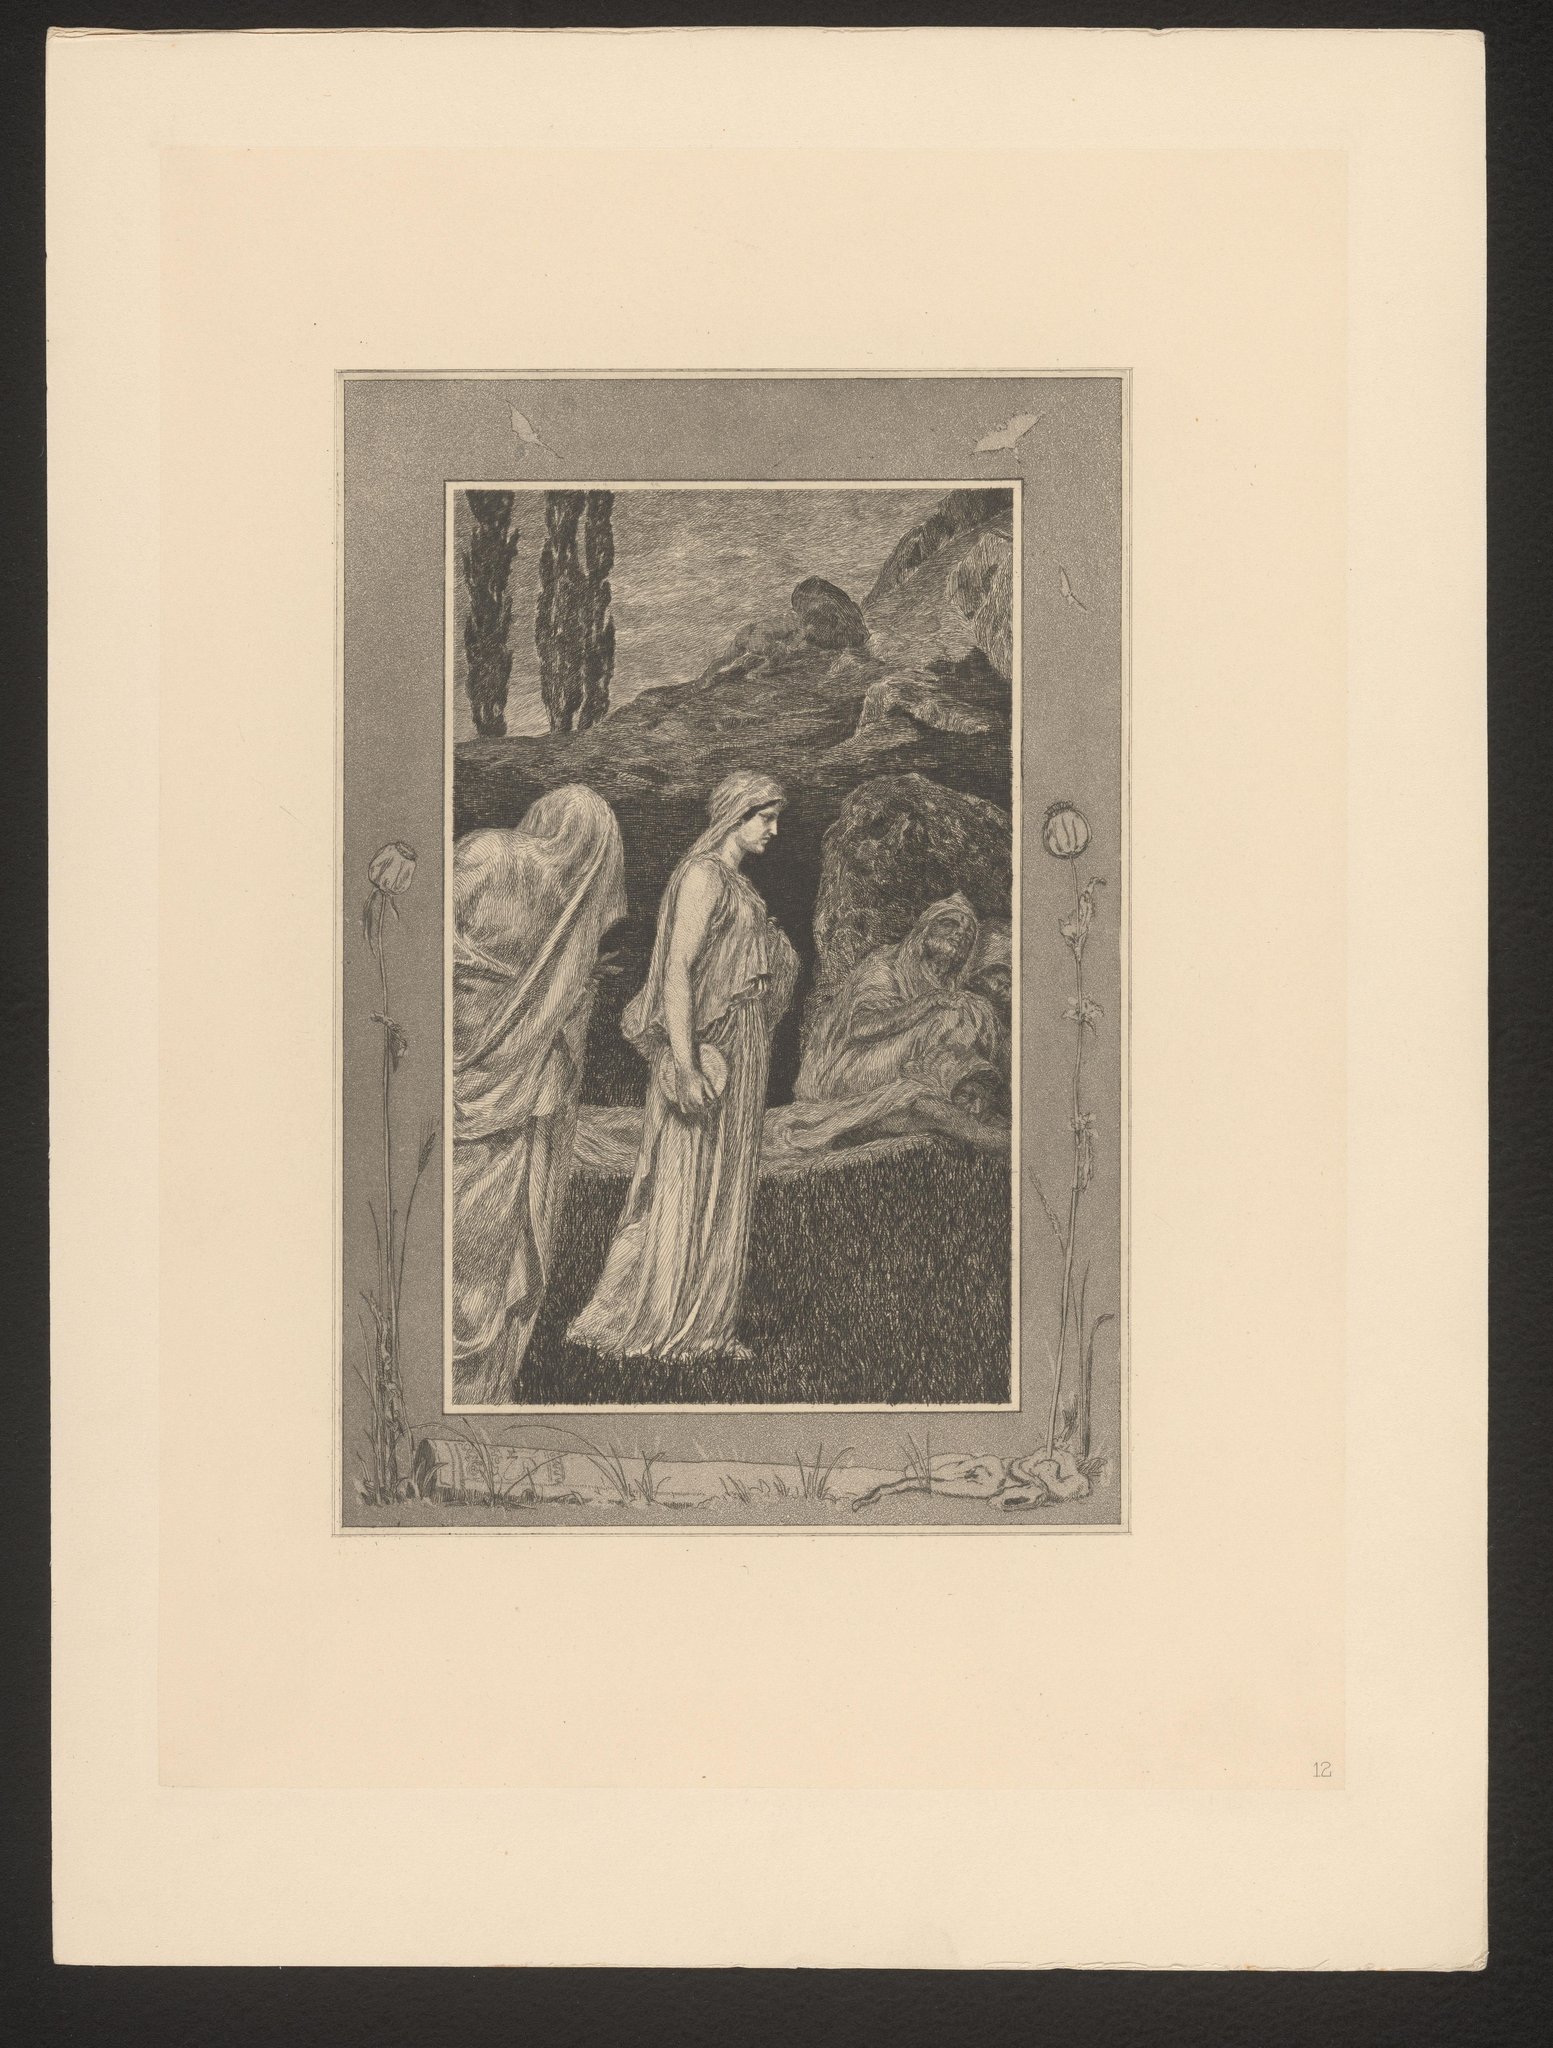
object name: print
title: Psyche in Tartarus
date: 1880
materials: paper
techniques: aquatint, etching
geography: nuremberg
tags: other scenes from the story of cupid and psyche, tartarus (and the condemned assigned there)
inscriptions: collector's mark: Lugt 2228